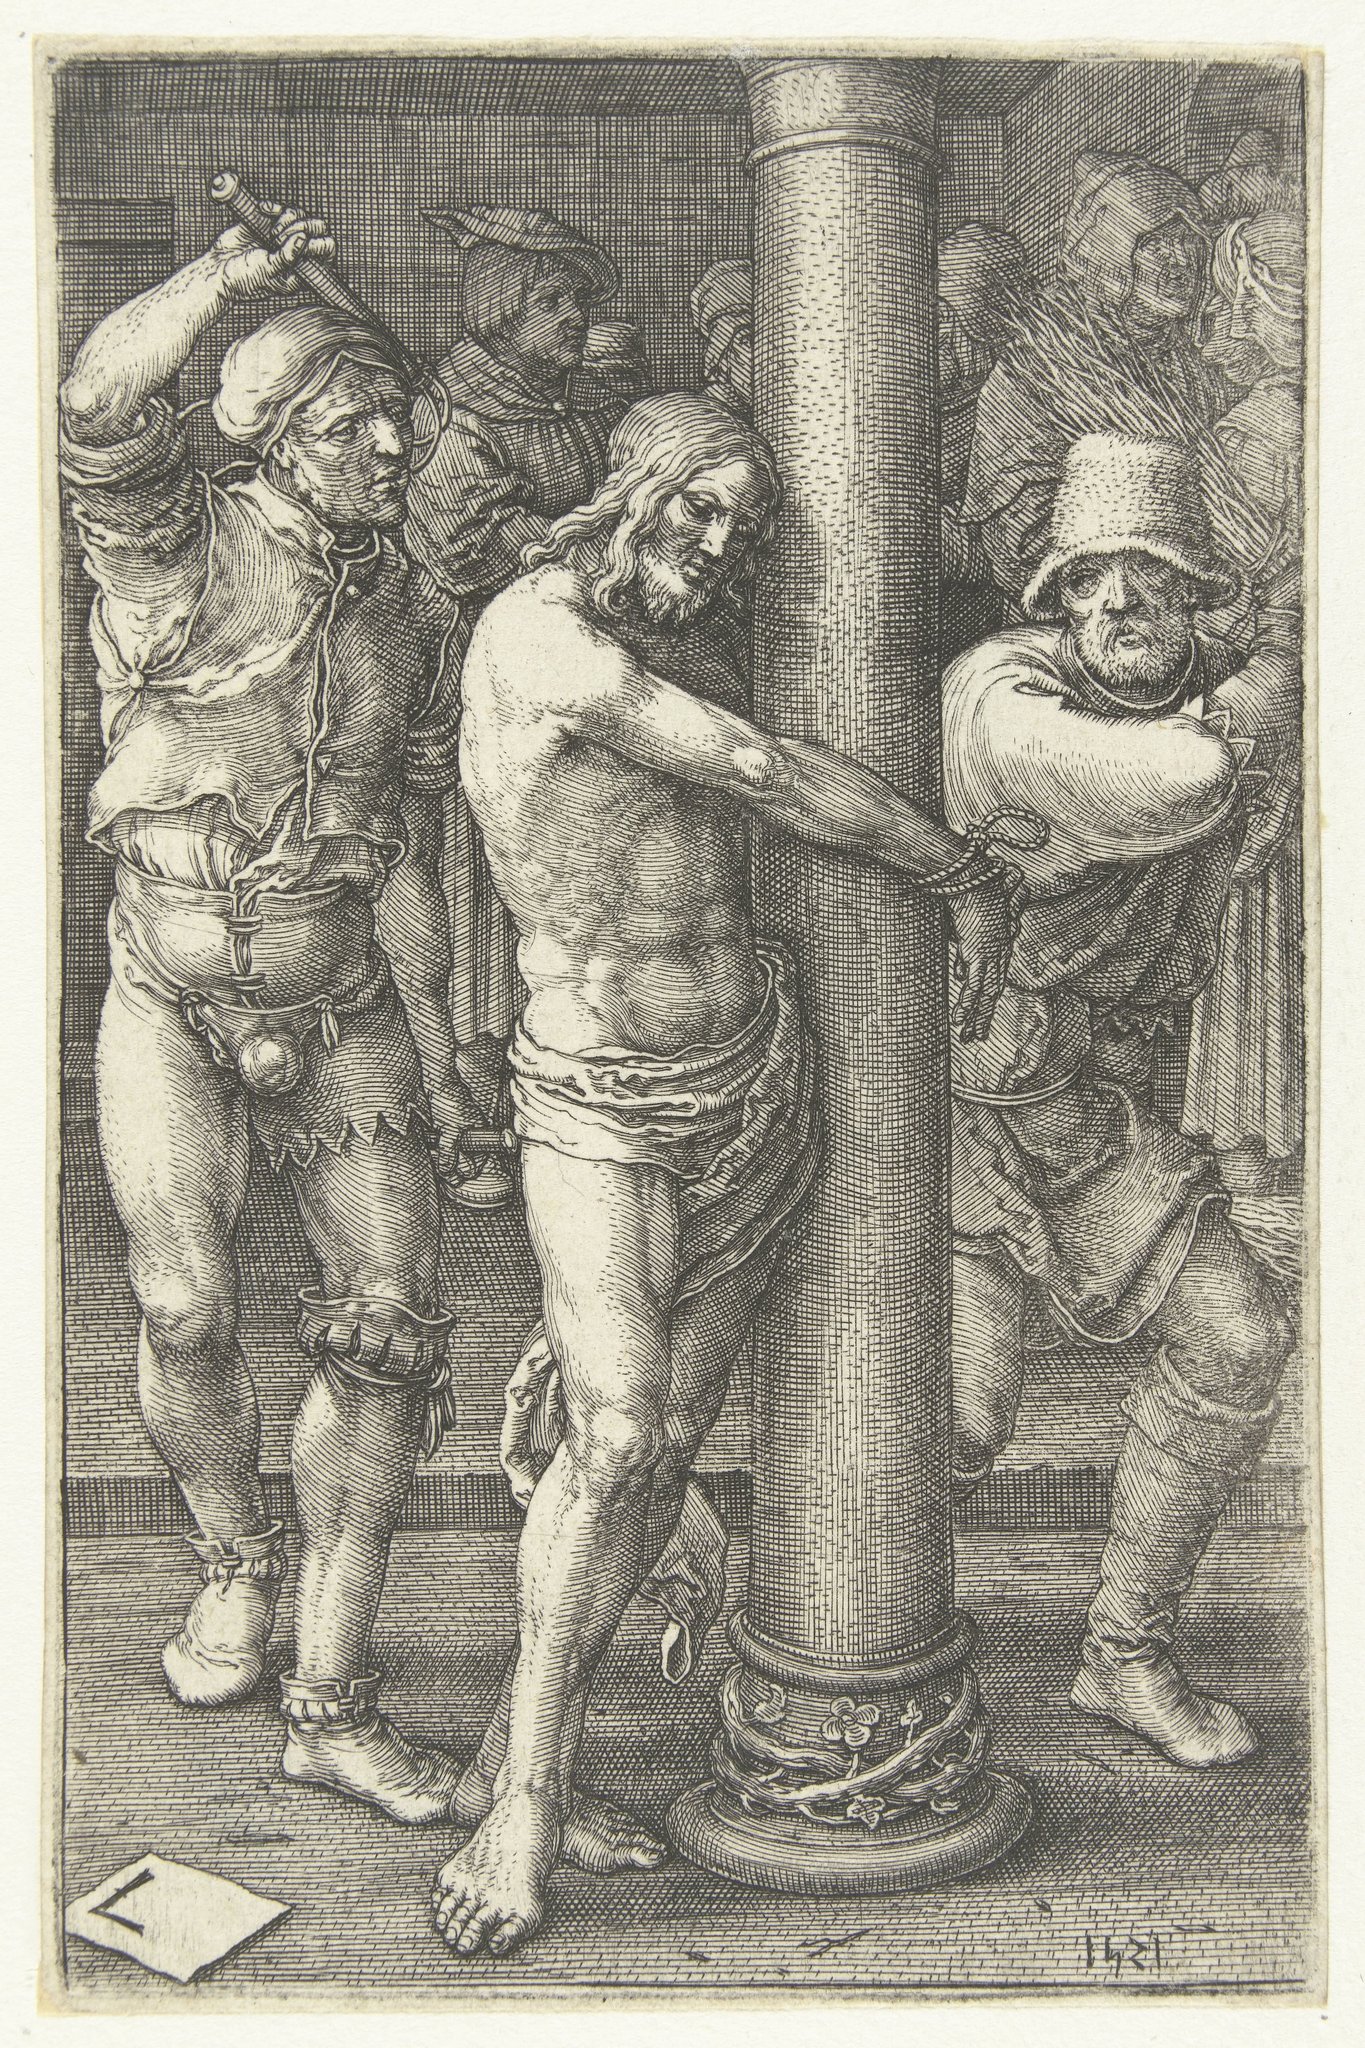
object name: print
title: De kleine Passie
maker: lucas van leyden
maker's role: draughtsman, painter, print maker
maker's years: 1494-1533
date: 1521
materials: paper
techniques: engraving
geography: low countries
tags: flagellation by soldiers, christ usually tied to a column (matthew 27:26; mark 15:15; john 19:1)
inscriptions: date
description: Christus vastgebonden aan een zuil, wordt gegeseld met een zweep en roe door twee mannen.